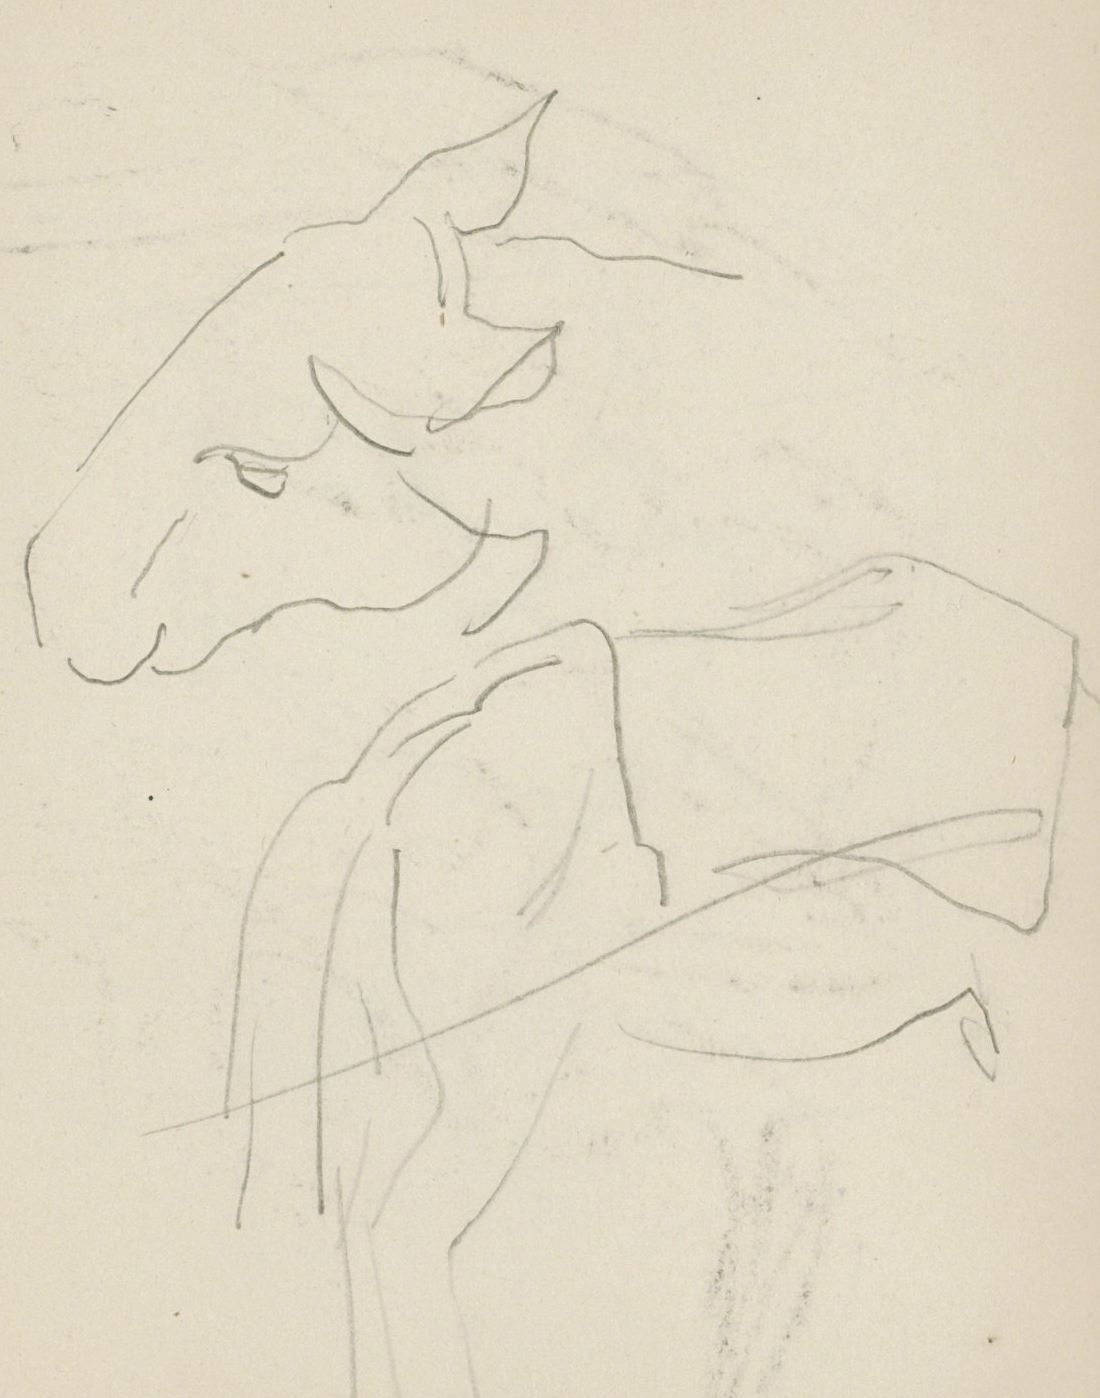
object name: sketchbook leaf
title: Paard en een kop van een ezel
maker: reijer stolk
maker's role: draughtsman, print maker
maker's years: 1896-1945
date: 1906-1945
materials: paper, pencil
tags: horse, mule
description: Het paard heeft een deken op de rug. Blad 16 recto uit een schetsboek met 69 bladen.